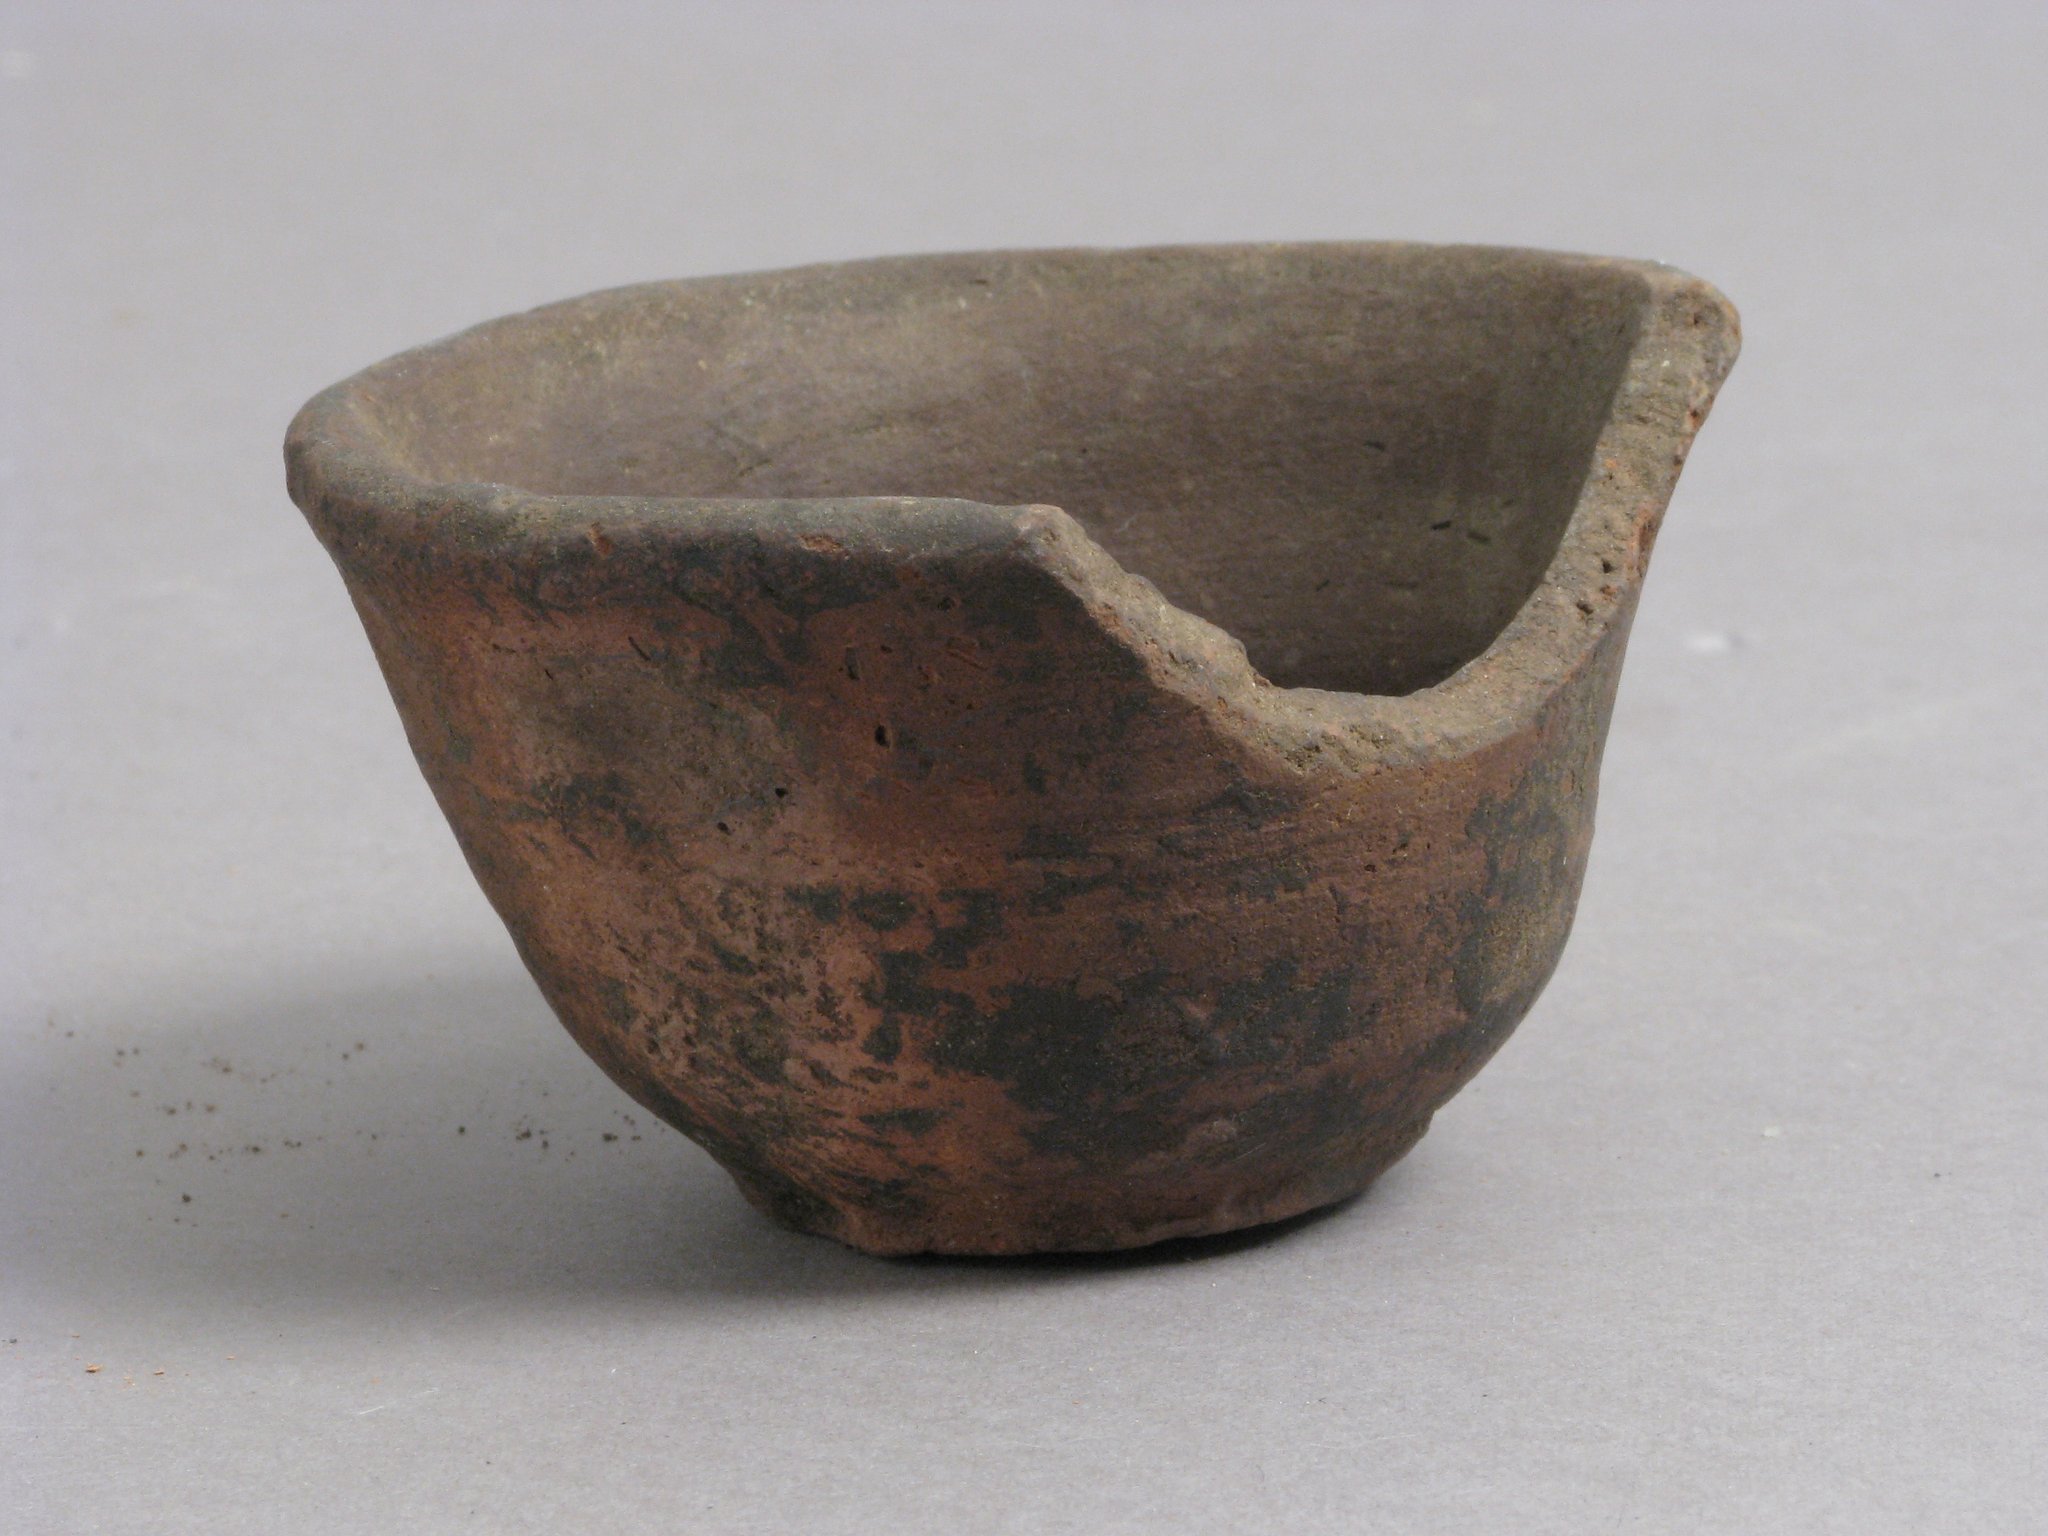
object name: bowl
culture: coptic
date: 301-700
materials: earthenware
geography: egypt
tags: bowls